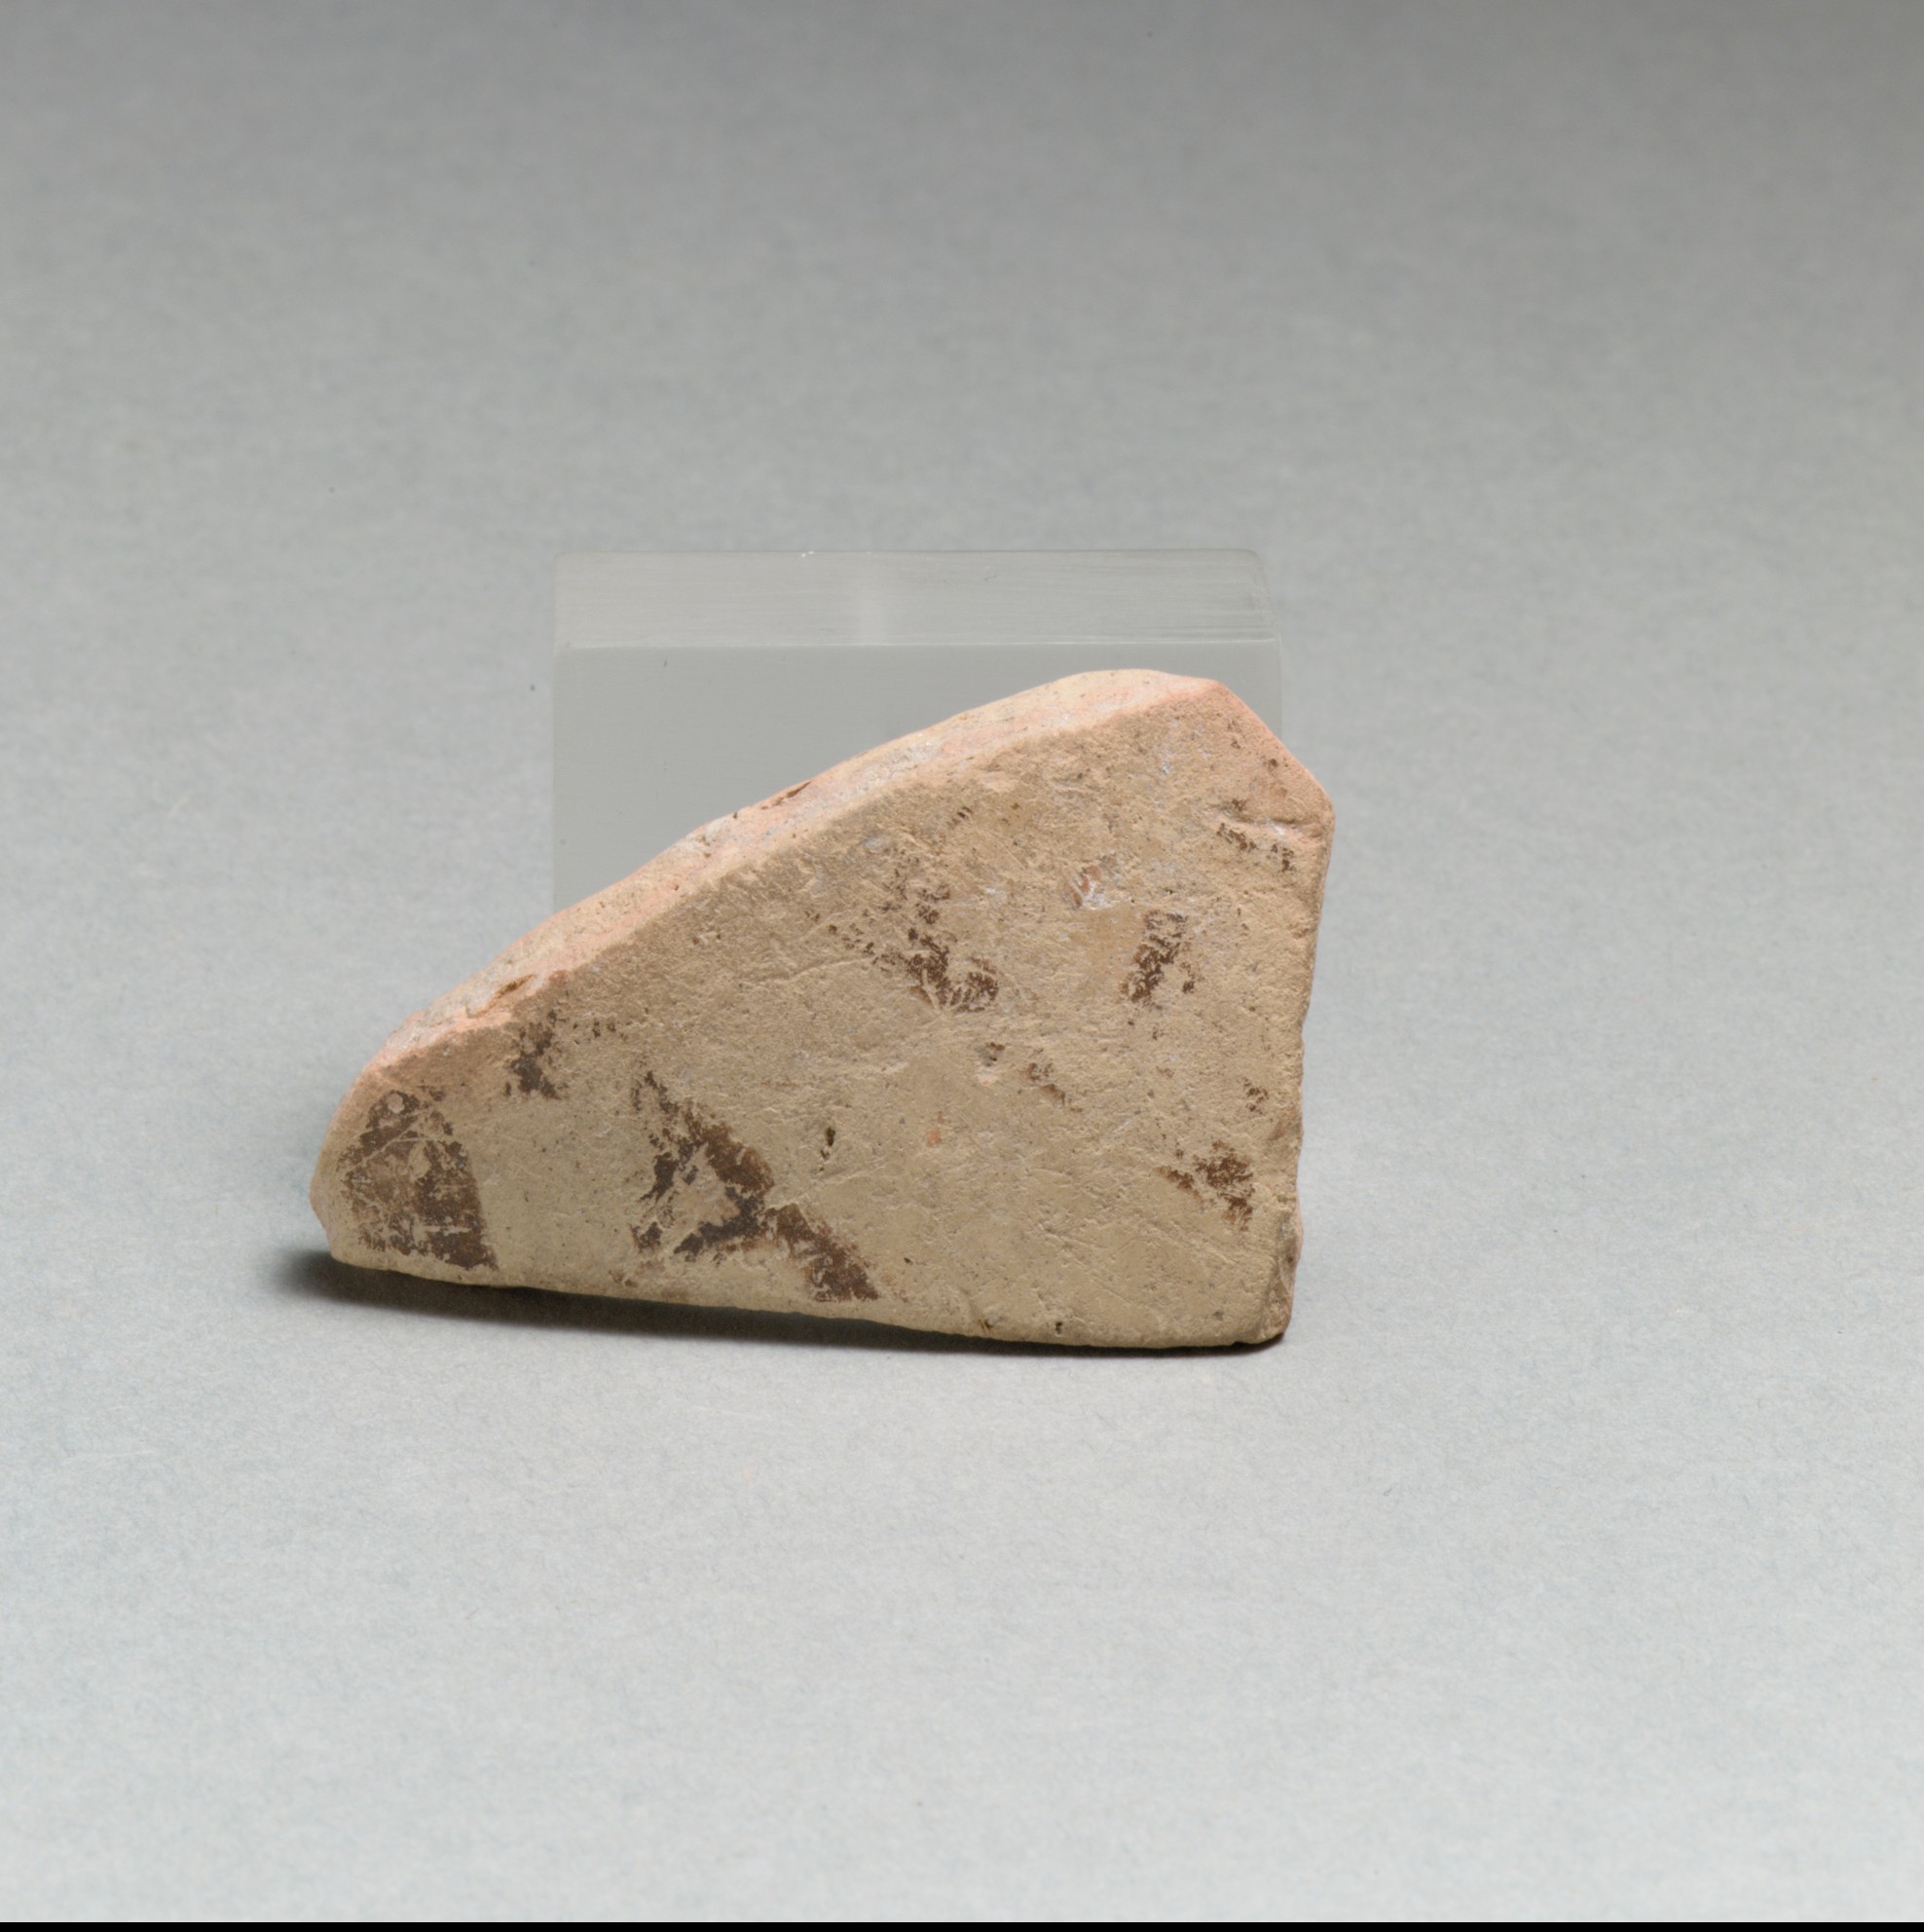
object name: vase fragment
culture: neolithic, thessaly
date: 4000-3000 BCE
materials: terracotta